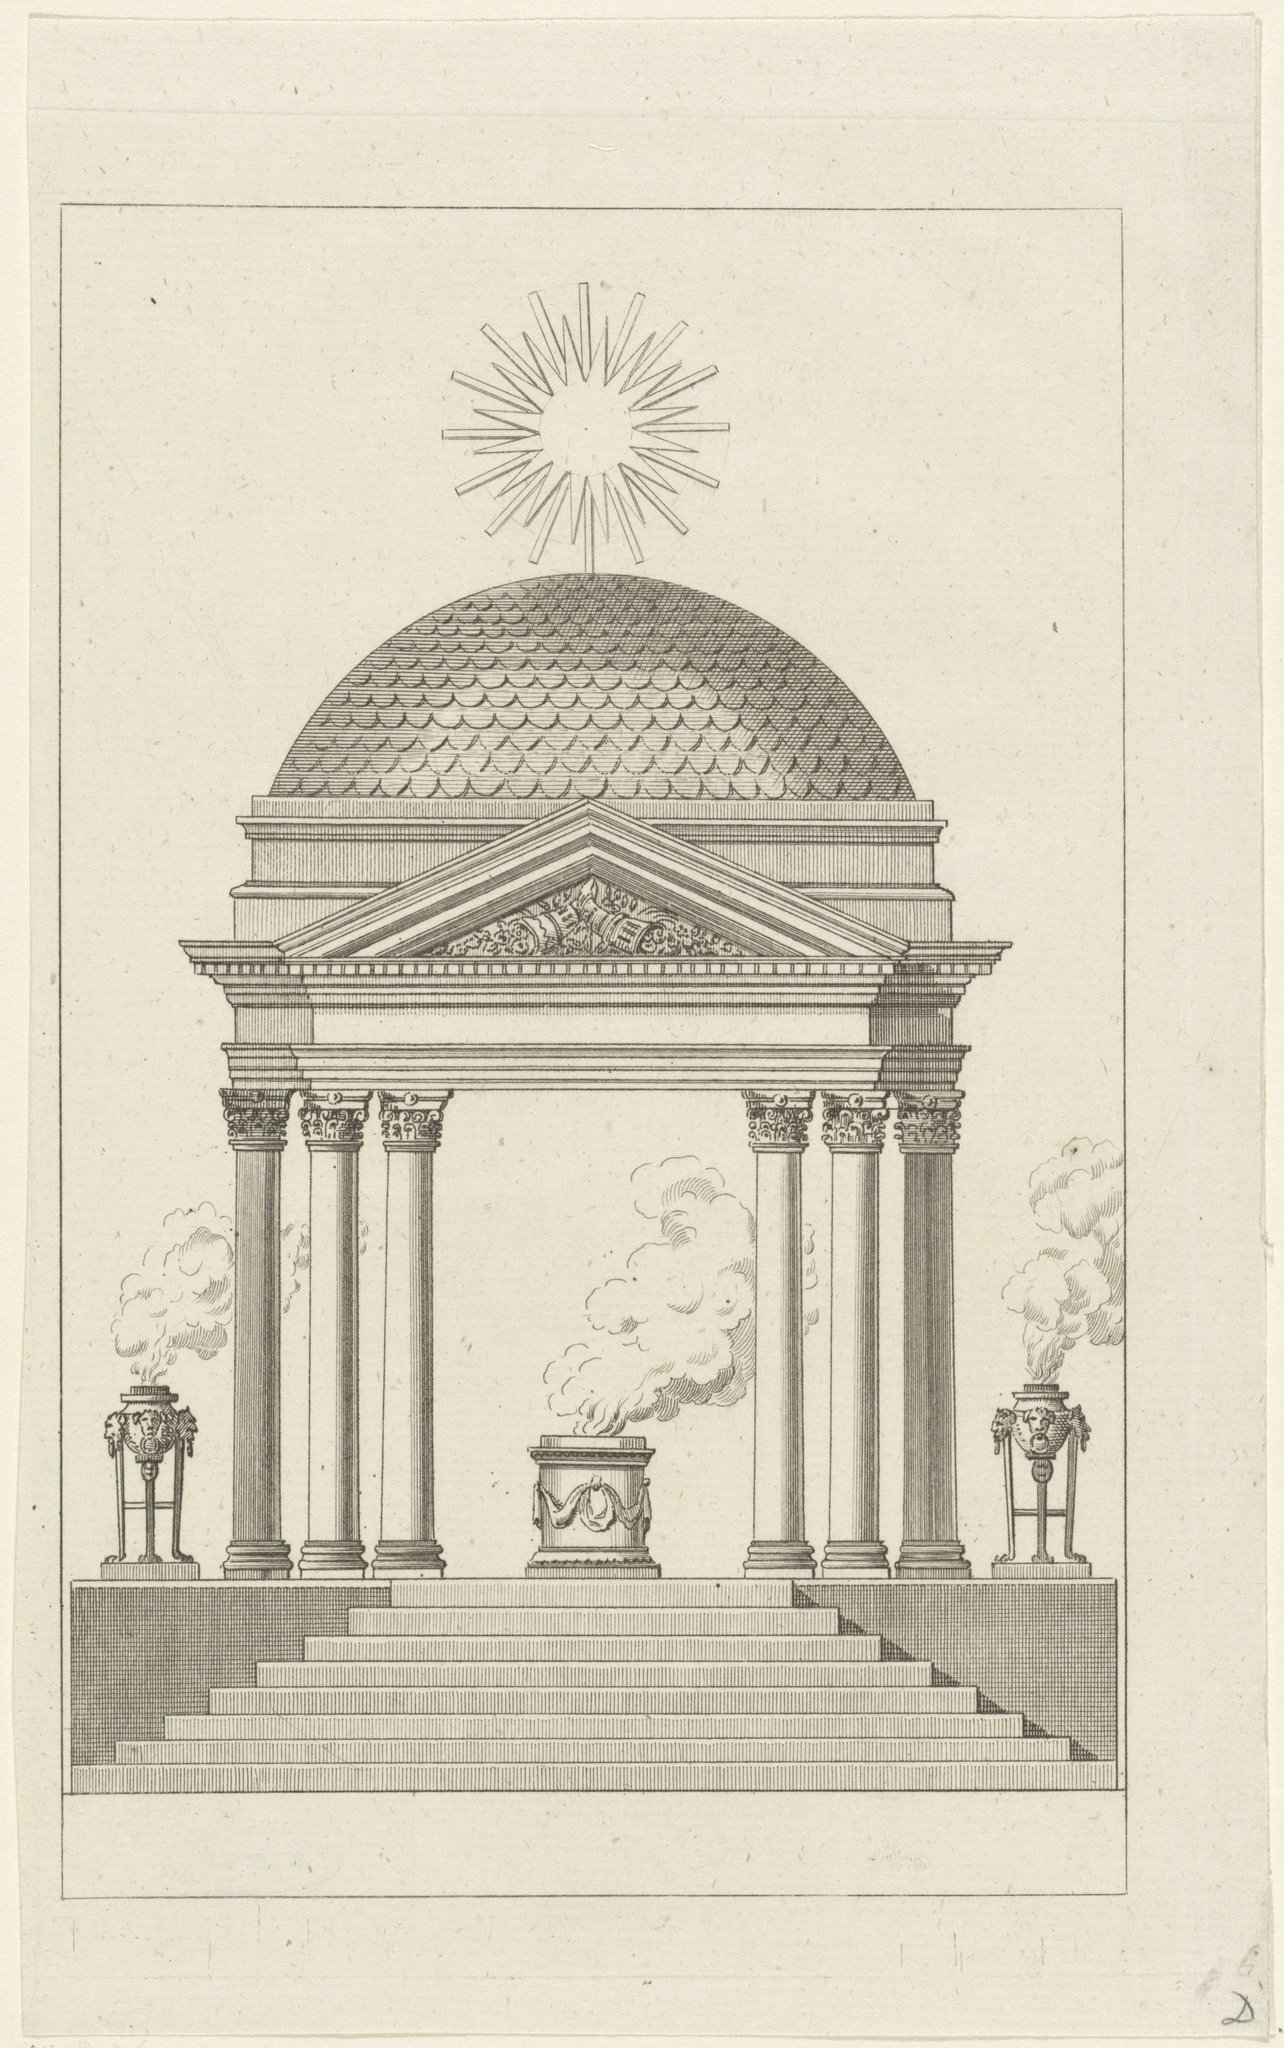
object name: print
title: Erepoort aan de Haarlemmerpoort, 1816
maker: antoni zürcher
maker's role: print maker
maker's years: 1754-1837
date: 1817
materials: paper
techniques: engraving, etching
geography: netherlands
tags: the hague, anna paulowna romanowa, william ii of the netherlands, public festivities on the occasion of royal events (+ decorated staff, portable structure ~ festive activities), triumphal arch, amsterdam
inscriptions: collector's mark: Lugt 2228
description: Gebruikt als illustratie in: Bruining, Gerbrand. Het verheugde Nederland, bij de aankomst van het te St. Petersburg gehuwde jeugdige vorstenpaar in de noordelijke en zuidelijke provinciën des Koningrijks, en de blijde geboorte der koninklijke telg uit dien heilvollen echt. Leiden: Leendert Herdingh en zoon, 1817.